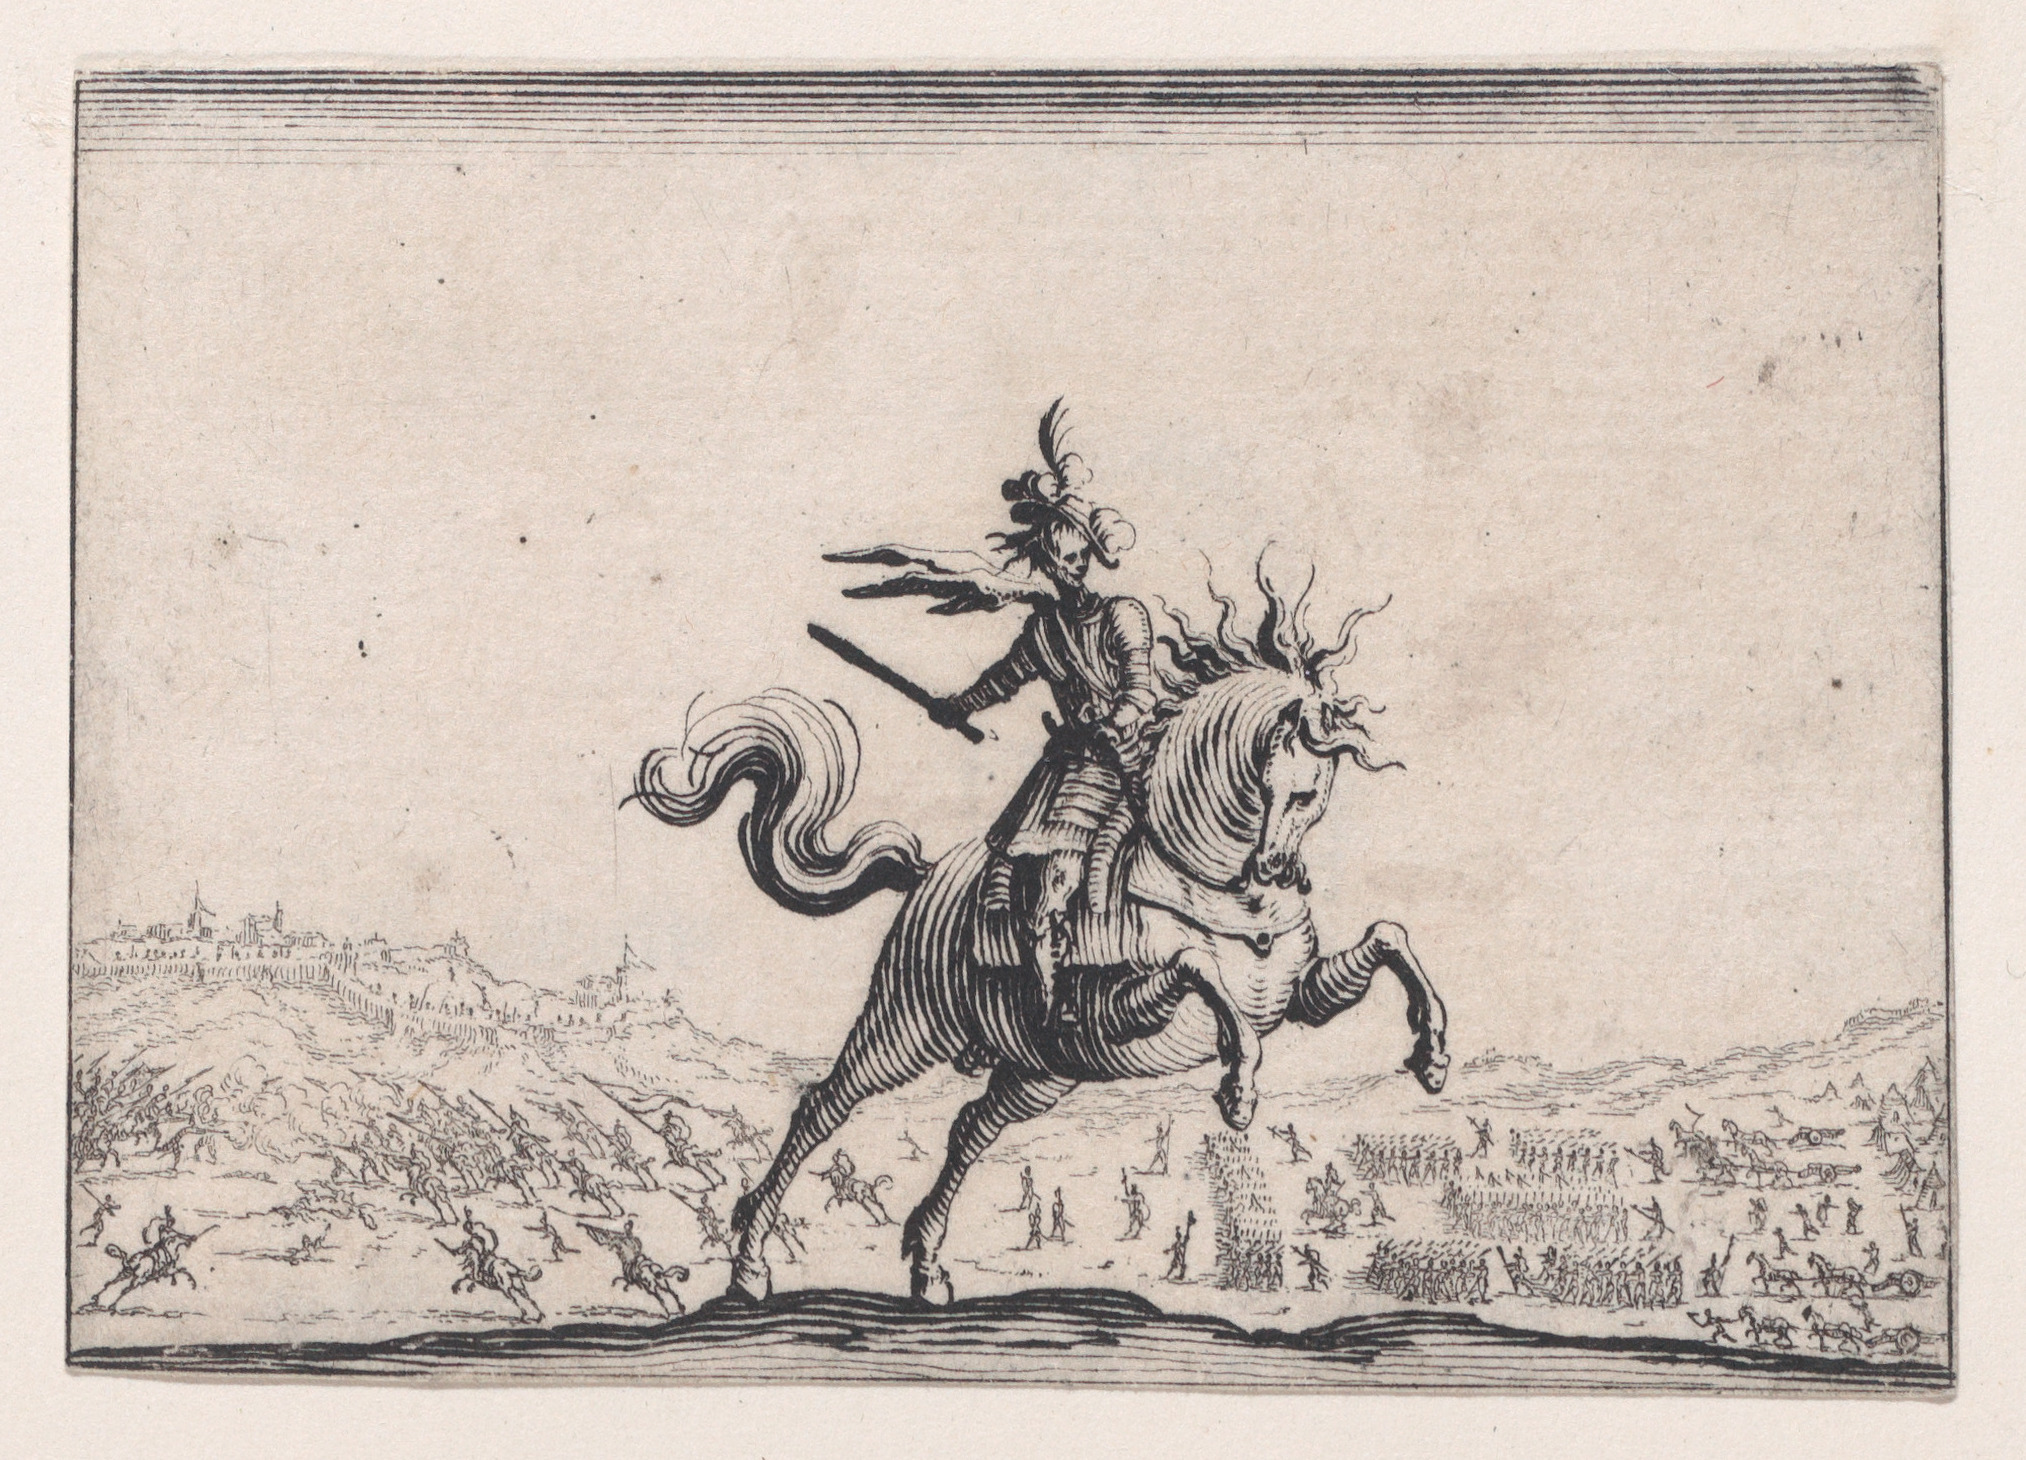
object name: print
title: Le Commandant a Cheval (The Commander on Horseback), from "Les Caprices" Series A, The Florence Set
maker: jacques callot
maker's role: artist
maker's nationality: french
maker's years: 1592-1635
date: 1617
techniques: etching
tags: men,horses